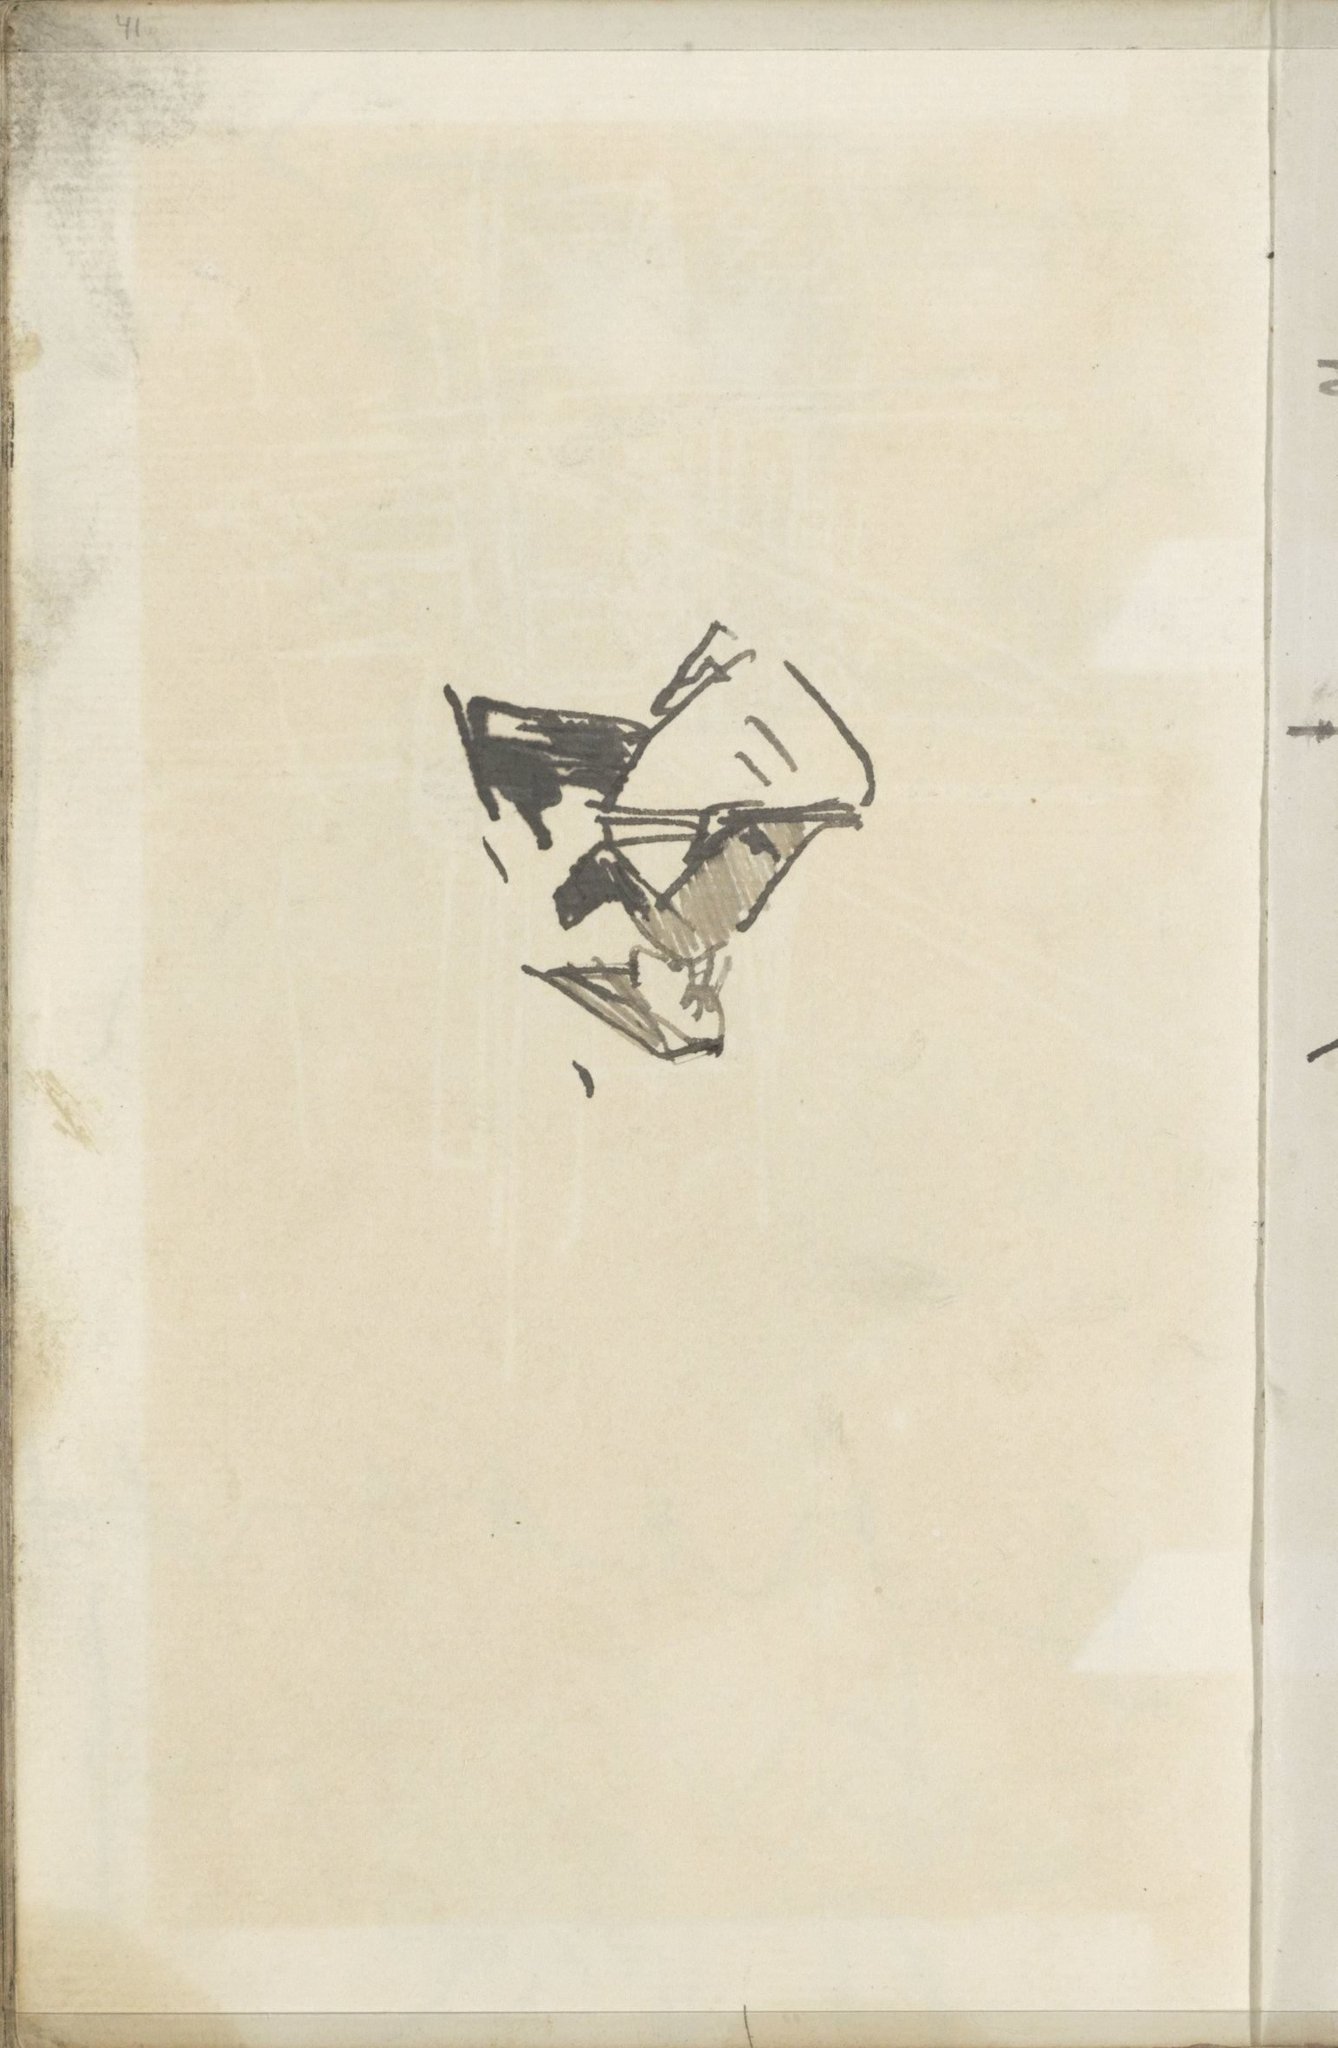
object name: sketchbook leaf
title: Studie, mogelijk van een hoofd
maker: george hendrik breitner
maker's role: draughtsman, painter, print maker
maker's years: 1857-1923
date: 1895-1898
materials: ink, paper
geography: amsterdam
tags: head (human)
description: Pagina 41 uit een schetsboek met 21 bladen.